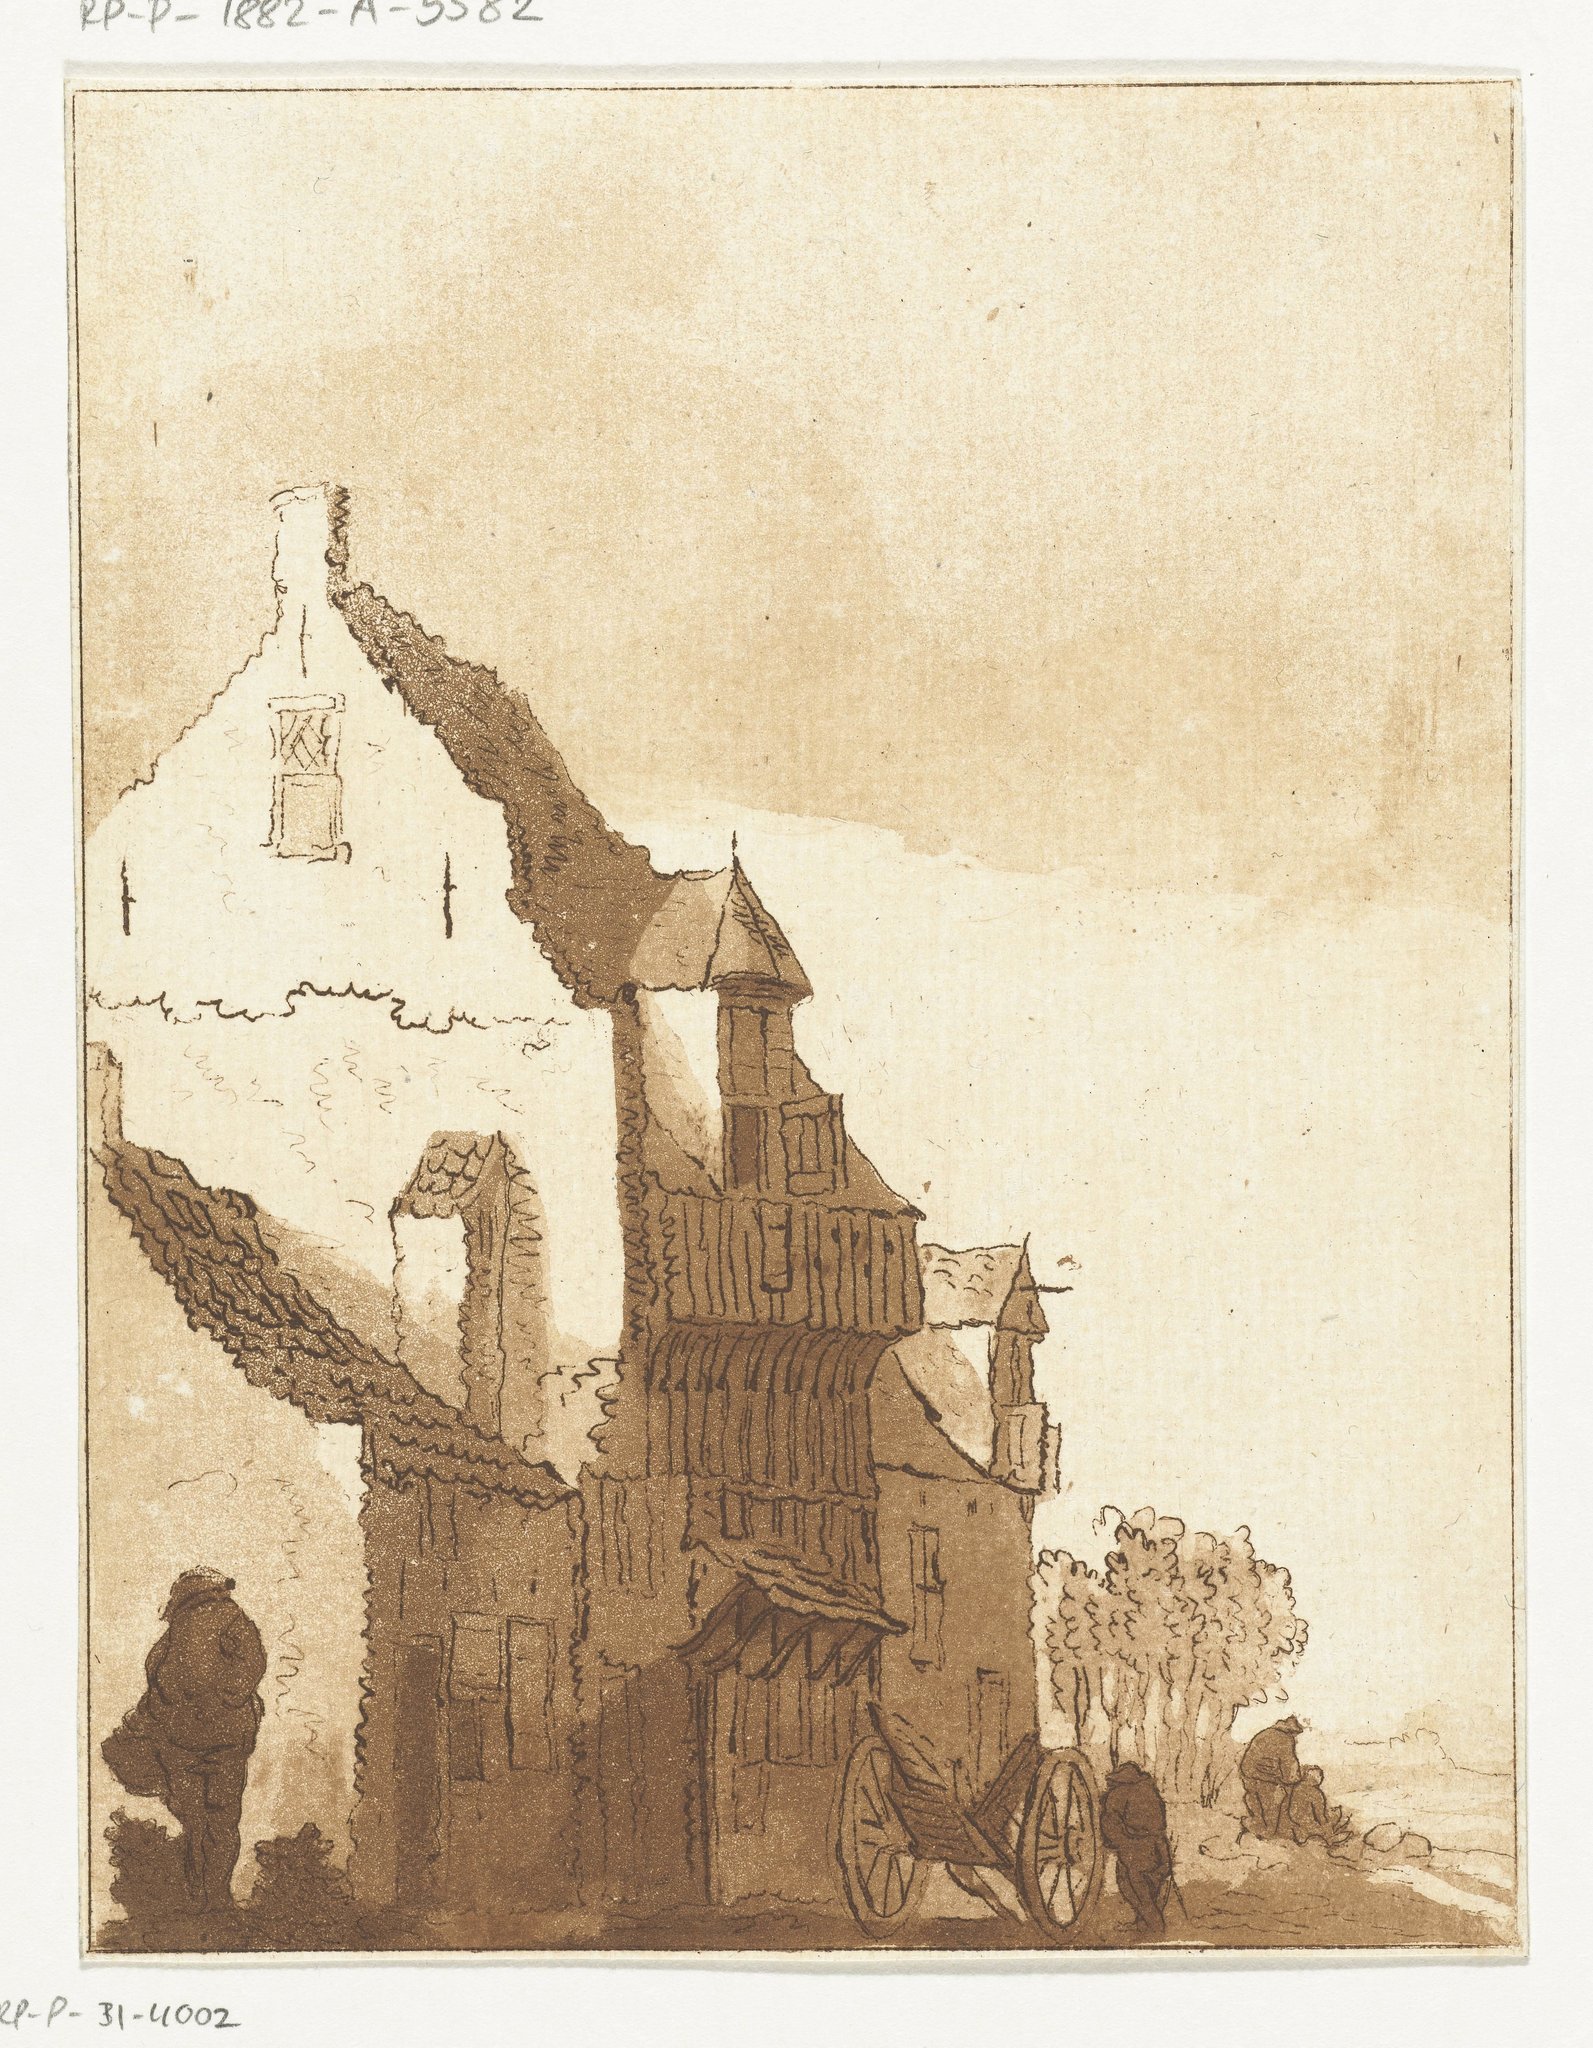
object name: print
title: Huis met kruiwagen voor de deur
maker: anthonie van den bos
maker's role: draughtsman, print maker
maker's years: 1763-1838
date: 1778-1838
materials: paper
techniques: aquatint, etching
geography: netherlands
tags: the usual house or row of houses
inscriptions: collector's mark: Lugt 2228